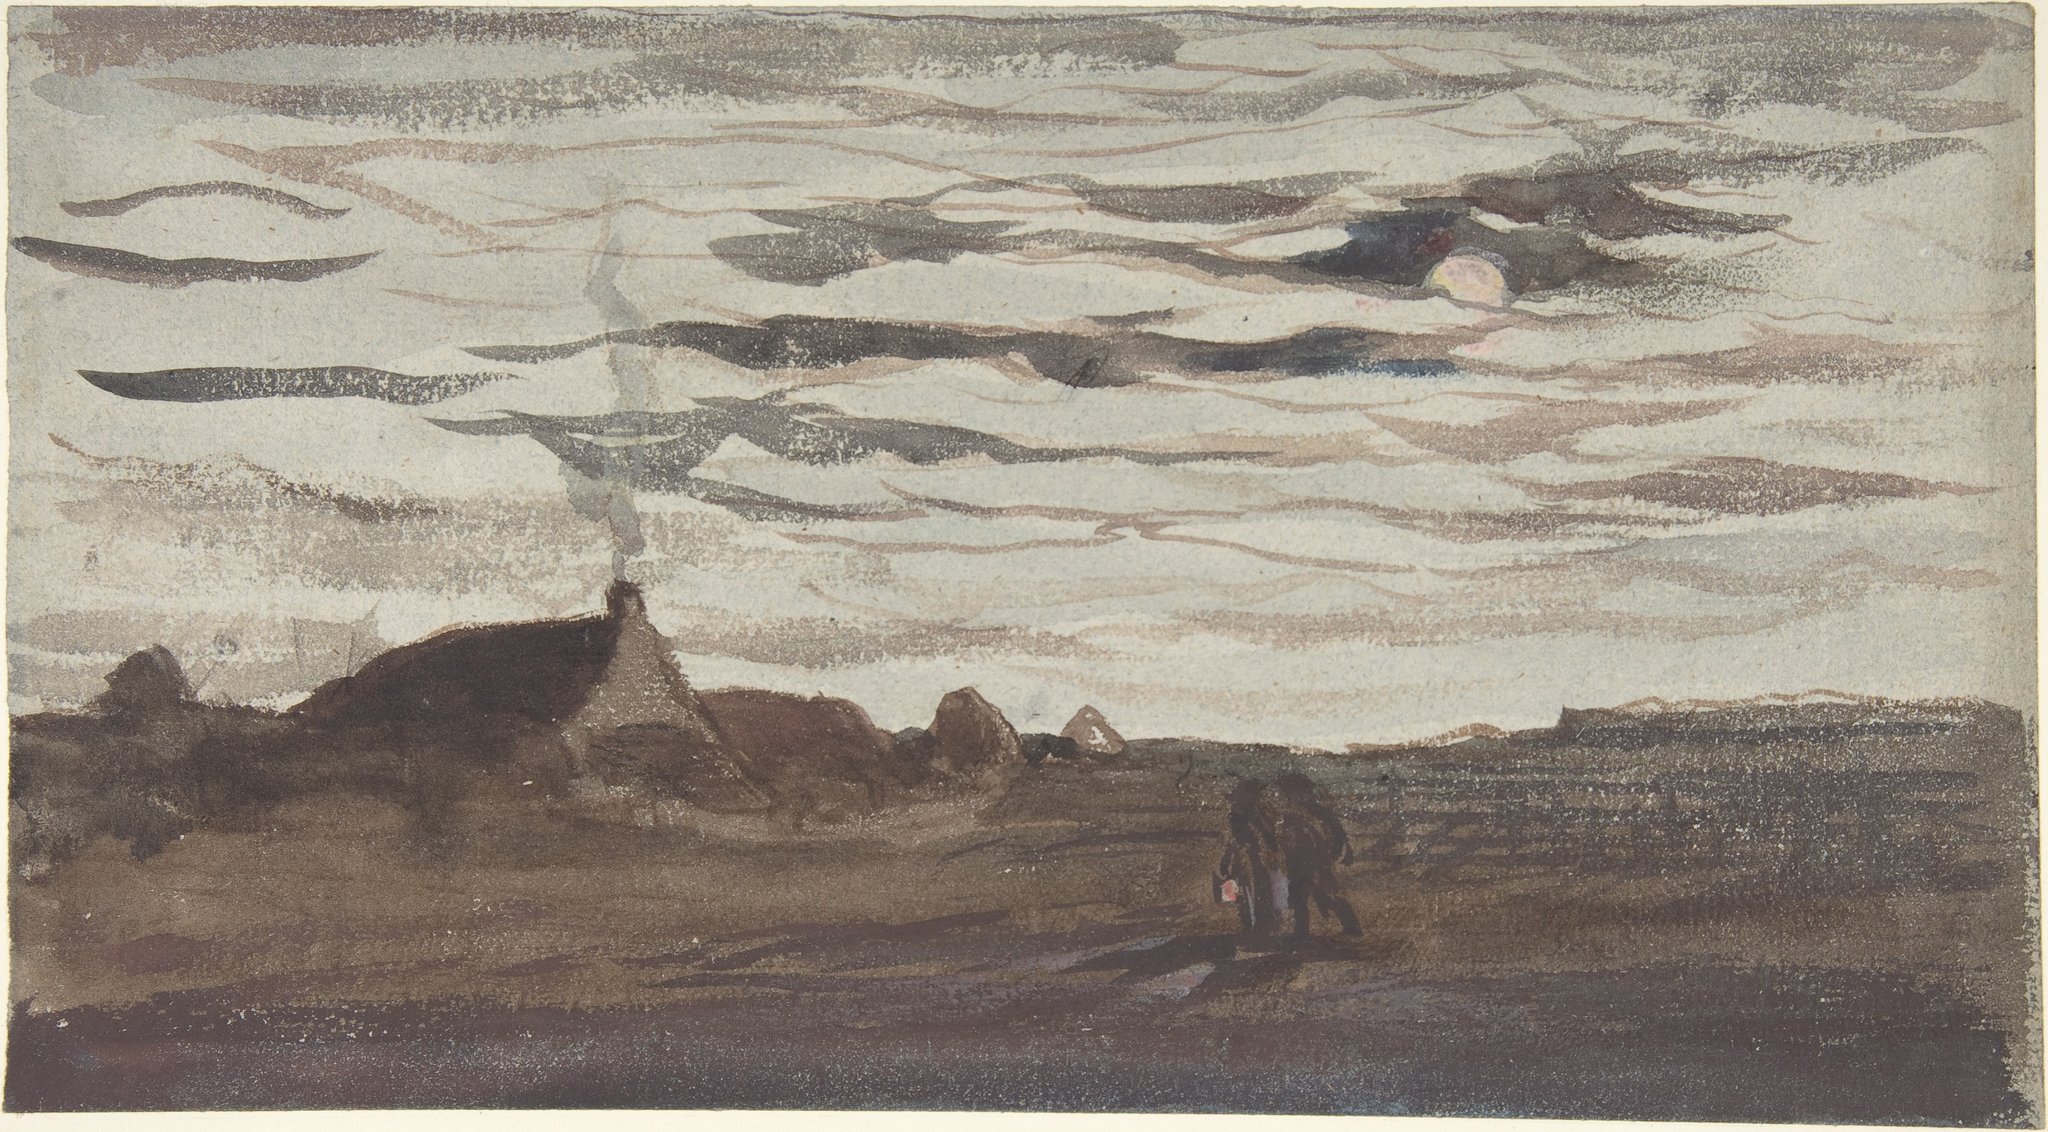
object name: drawing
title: Moonlight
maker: charles-françois daubigny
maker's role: artist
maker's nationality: french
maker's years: 1817-1878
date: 1860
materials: watercolor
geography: france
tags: moon,landscapes